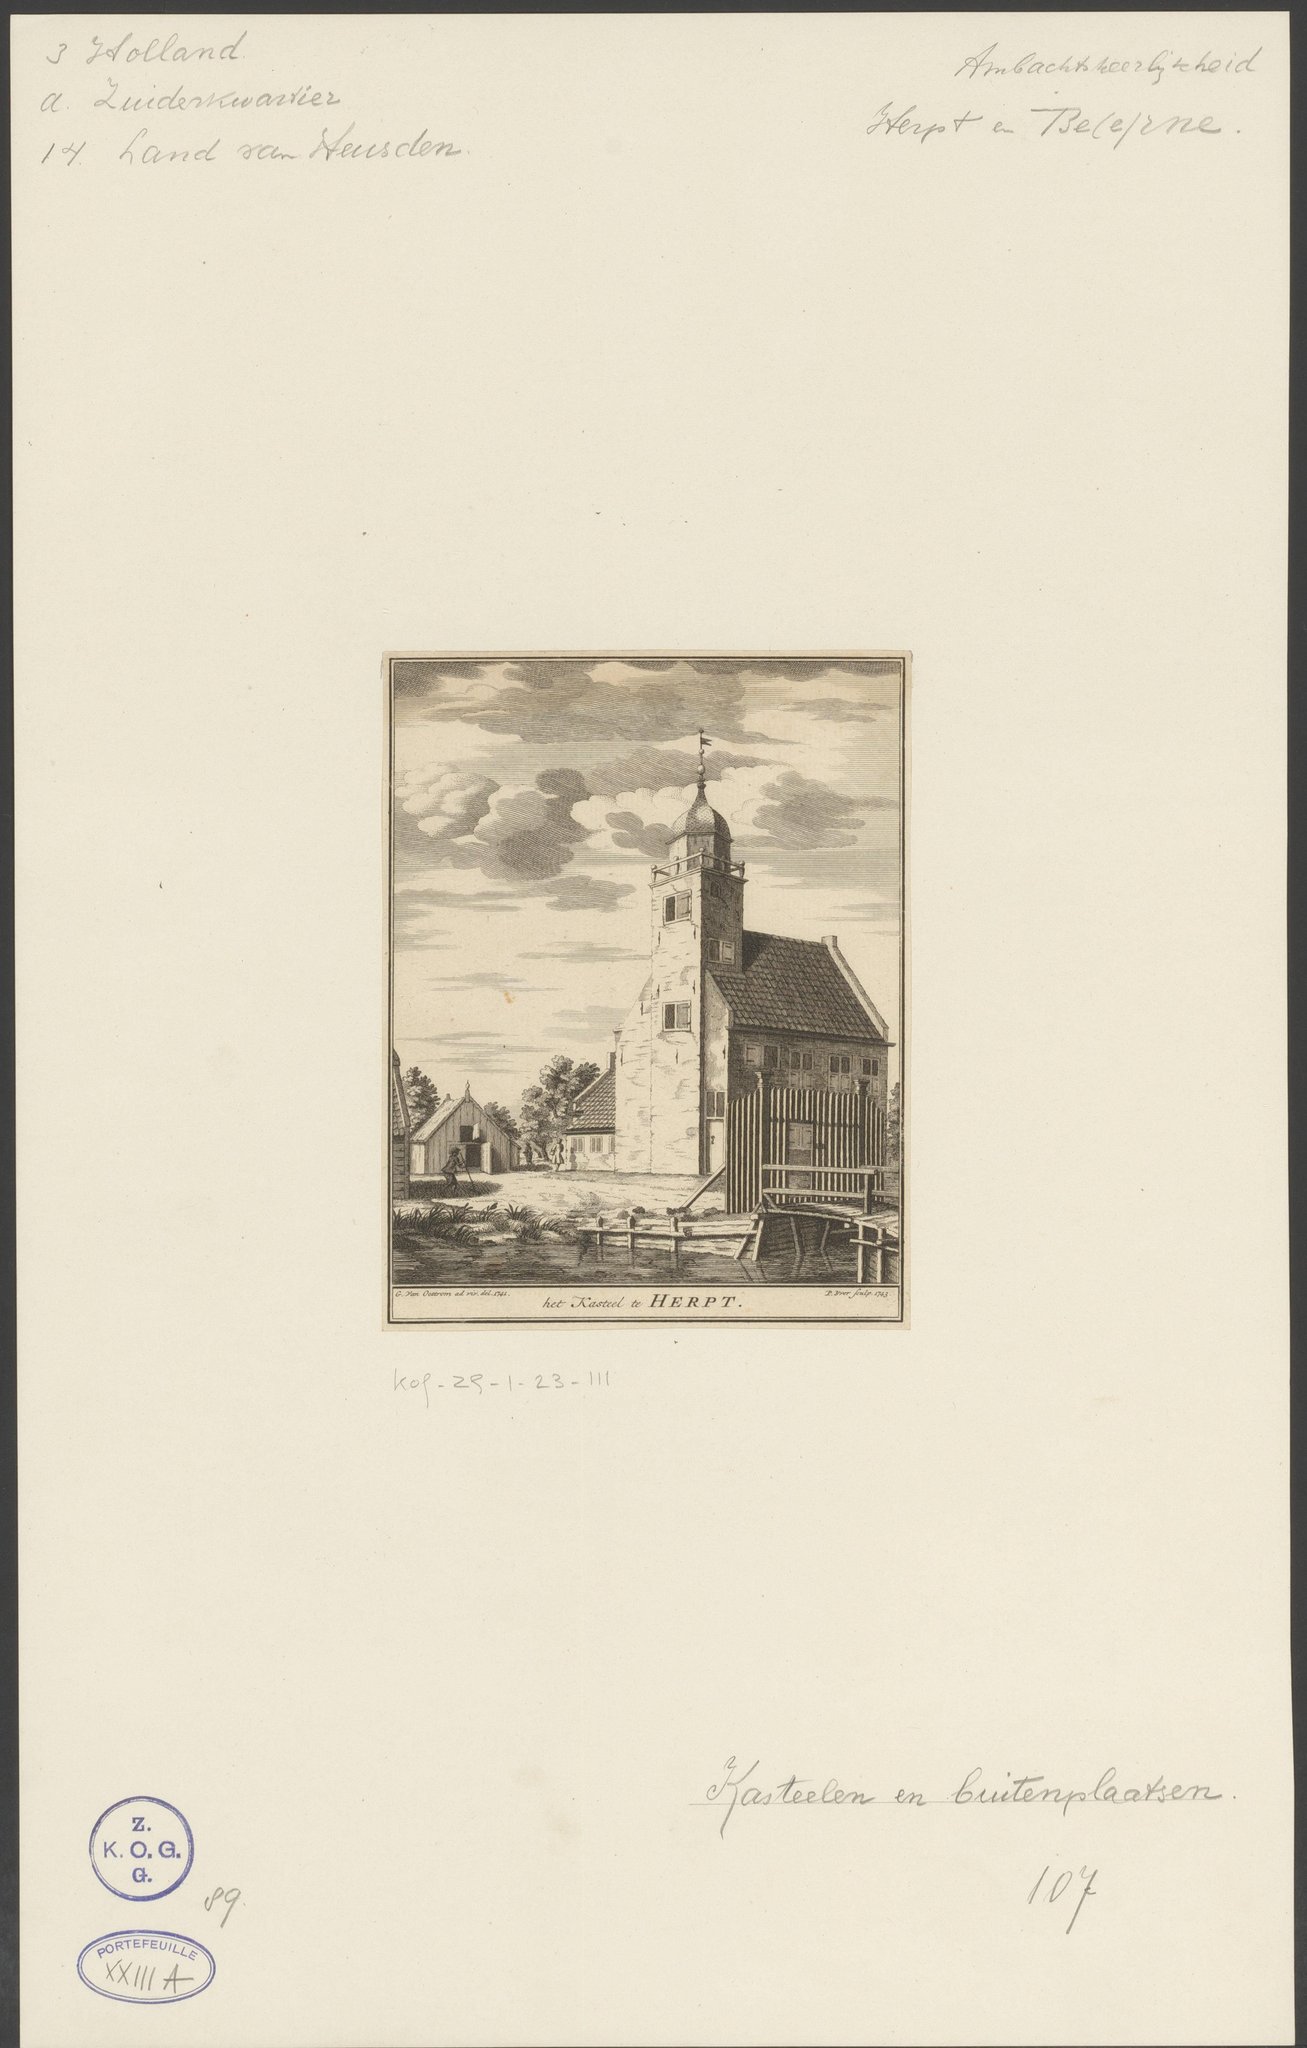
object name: print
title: Het Kasteel te Herpt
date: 1743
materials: paper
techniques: engraving, etching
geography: amsterdam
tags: landscape with tower or castle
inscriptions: collector's mark: Lugt 1641, stamp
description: Het kasteel te Herpt. Rechts een toegangsbrug. Onderwerpsrubrieken binnen de Atlas Zeden en Gewoonten: Zeden en Gewoonten in Engeren Zin, De Woning. Kastelen en buitenplaatsen. Holland (vervolg.)